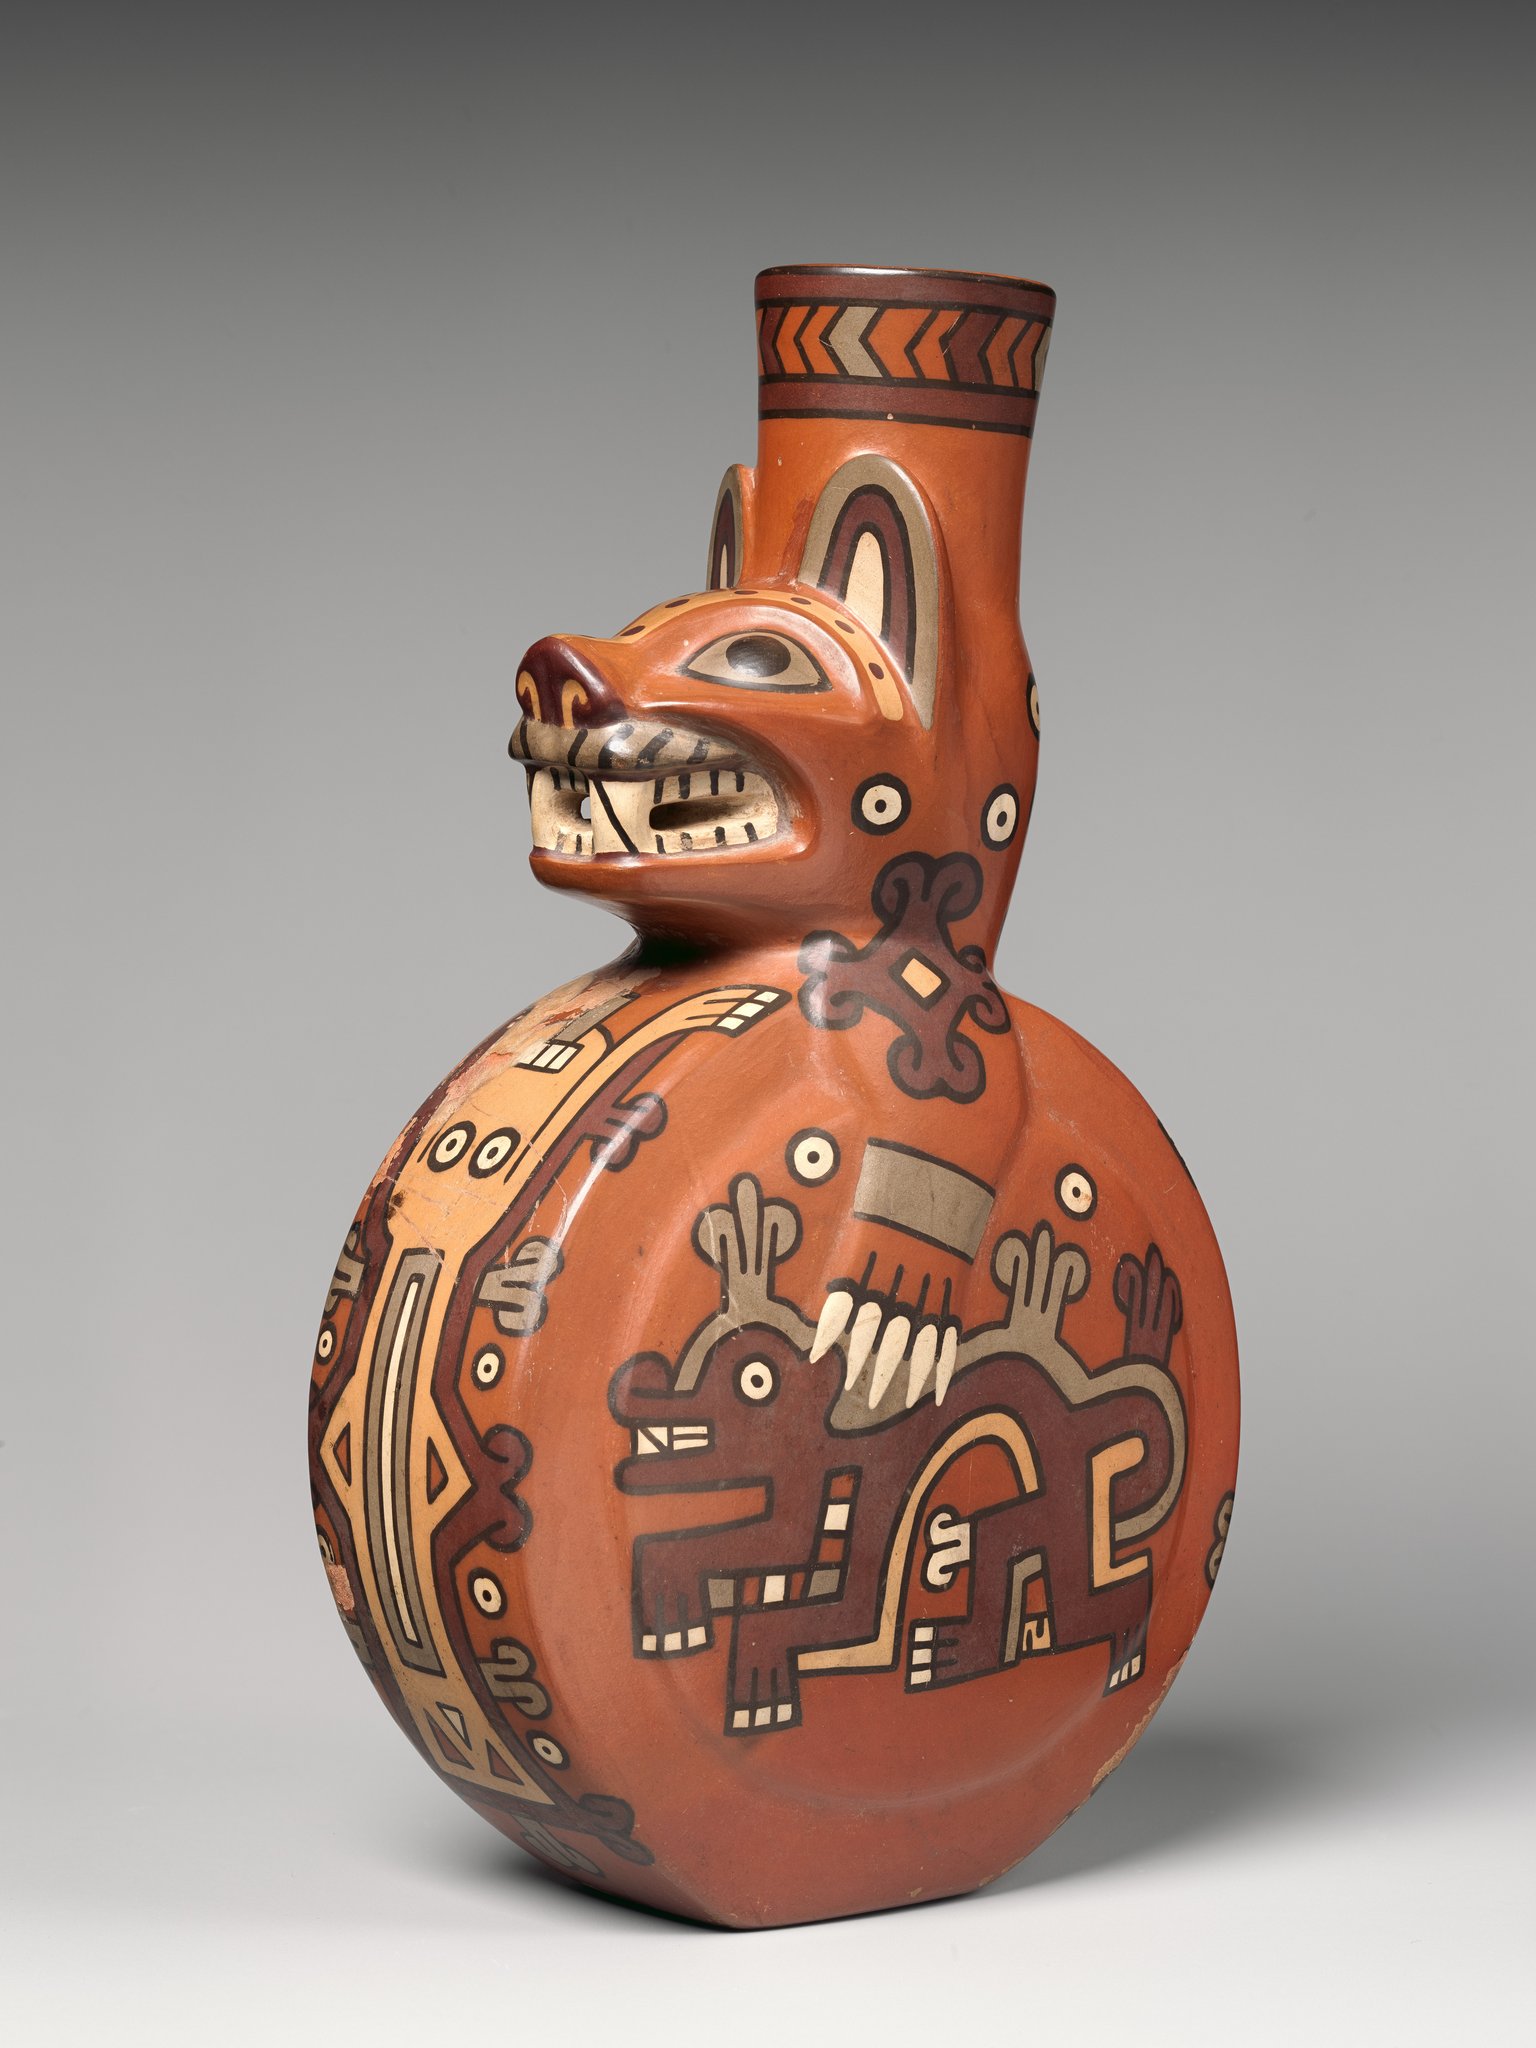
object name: bottle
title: Bottle in the shape of a feline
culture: wari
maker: wari artist(s)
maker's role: artist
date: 600-900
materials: ceramic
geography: peru